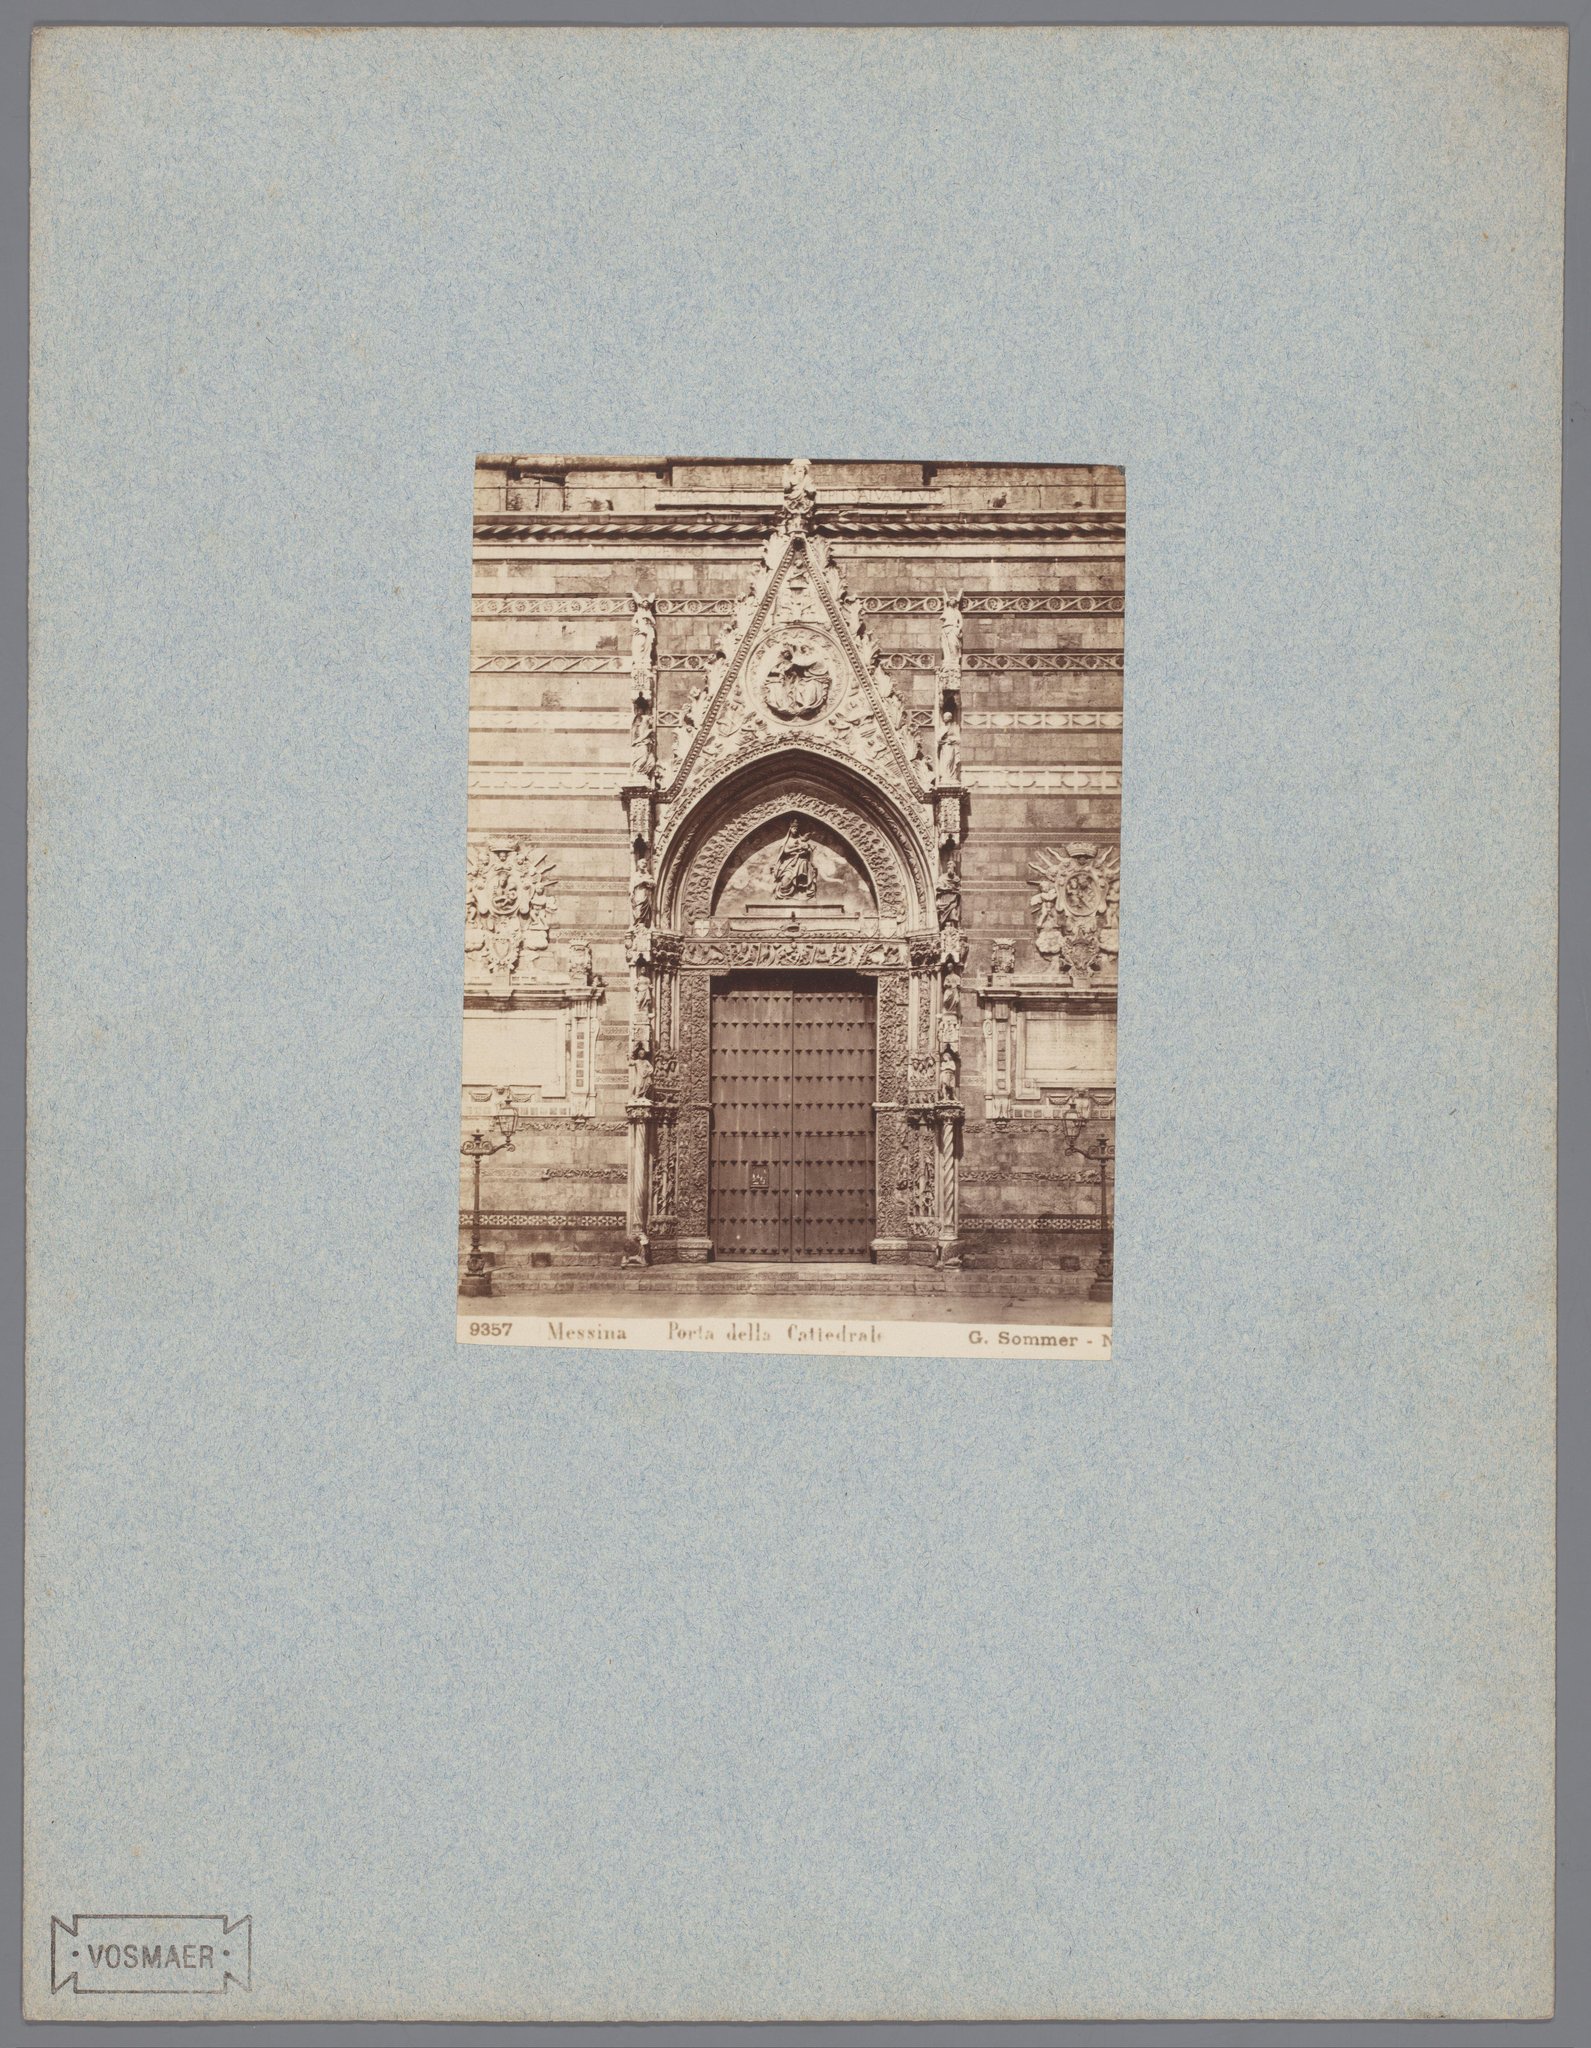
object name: photograph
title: Porta della Cattedrale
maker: giorgio sommer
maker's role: fotograaf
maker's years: 1834-1914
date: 1857-1914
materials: cardboard, paper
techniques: albumen print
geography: messina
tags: parts of church exterior and annexes (door), door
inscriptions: number: ‘9357’, collector's mark: ‘VOSMAER’